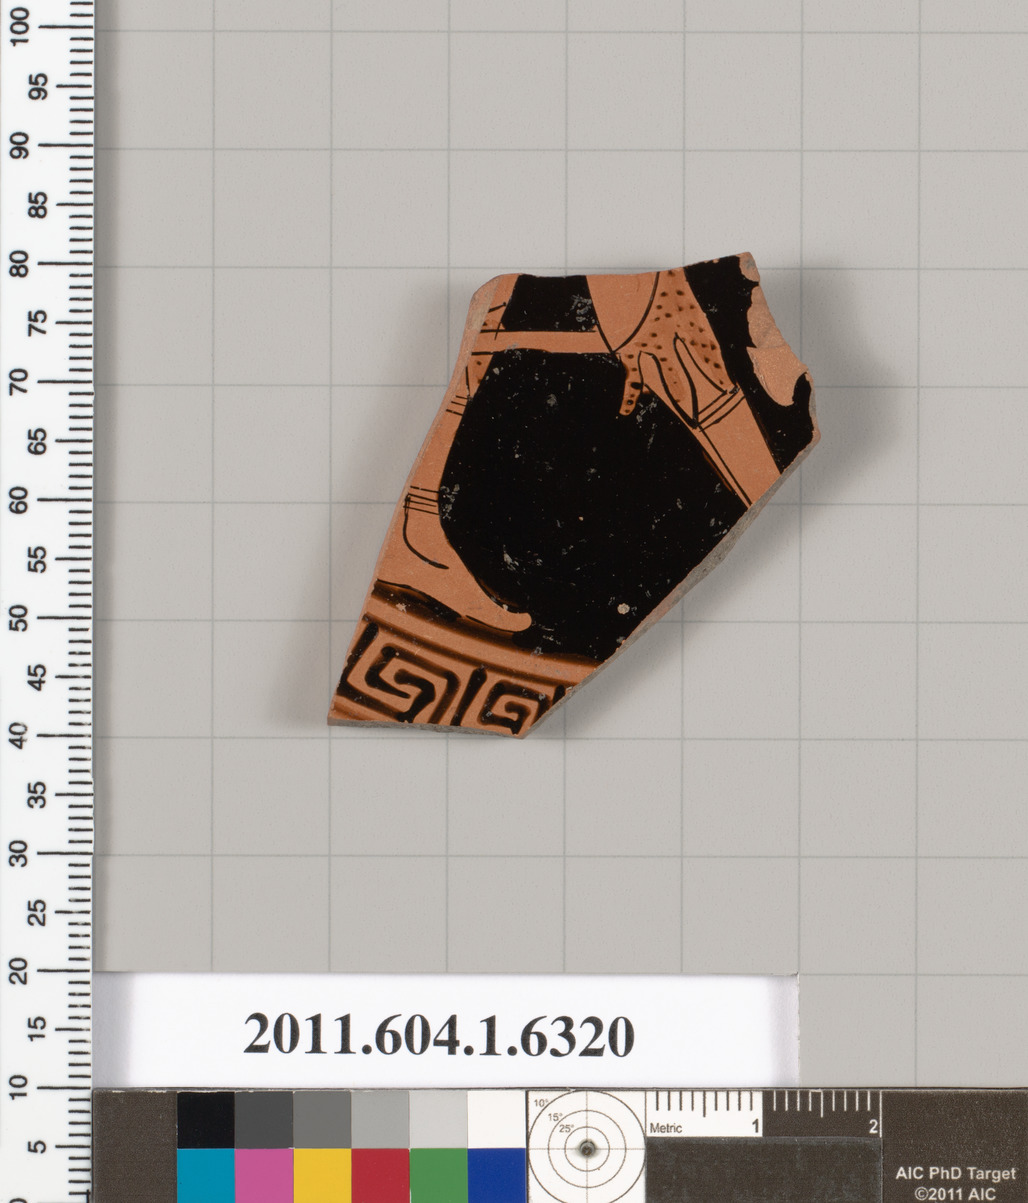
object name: kylix fragment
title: Terracotta fragment of a kylix (drinking cup)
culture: greek, attic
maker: onesimos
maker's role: artist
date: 500-480 BCE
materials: terracotta